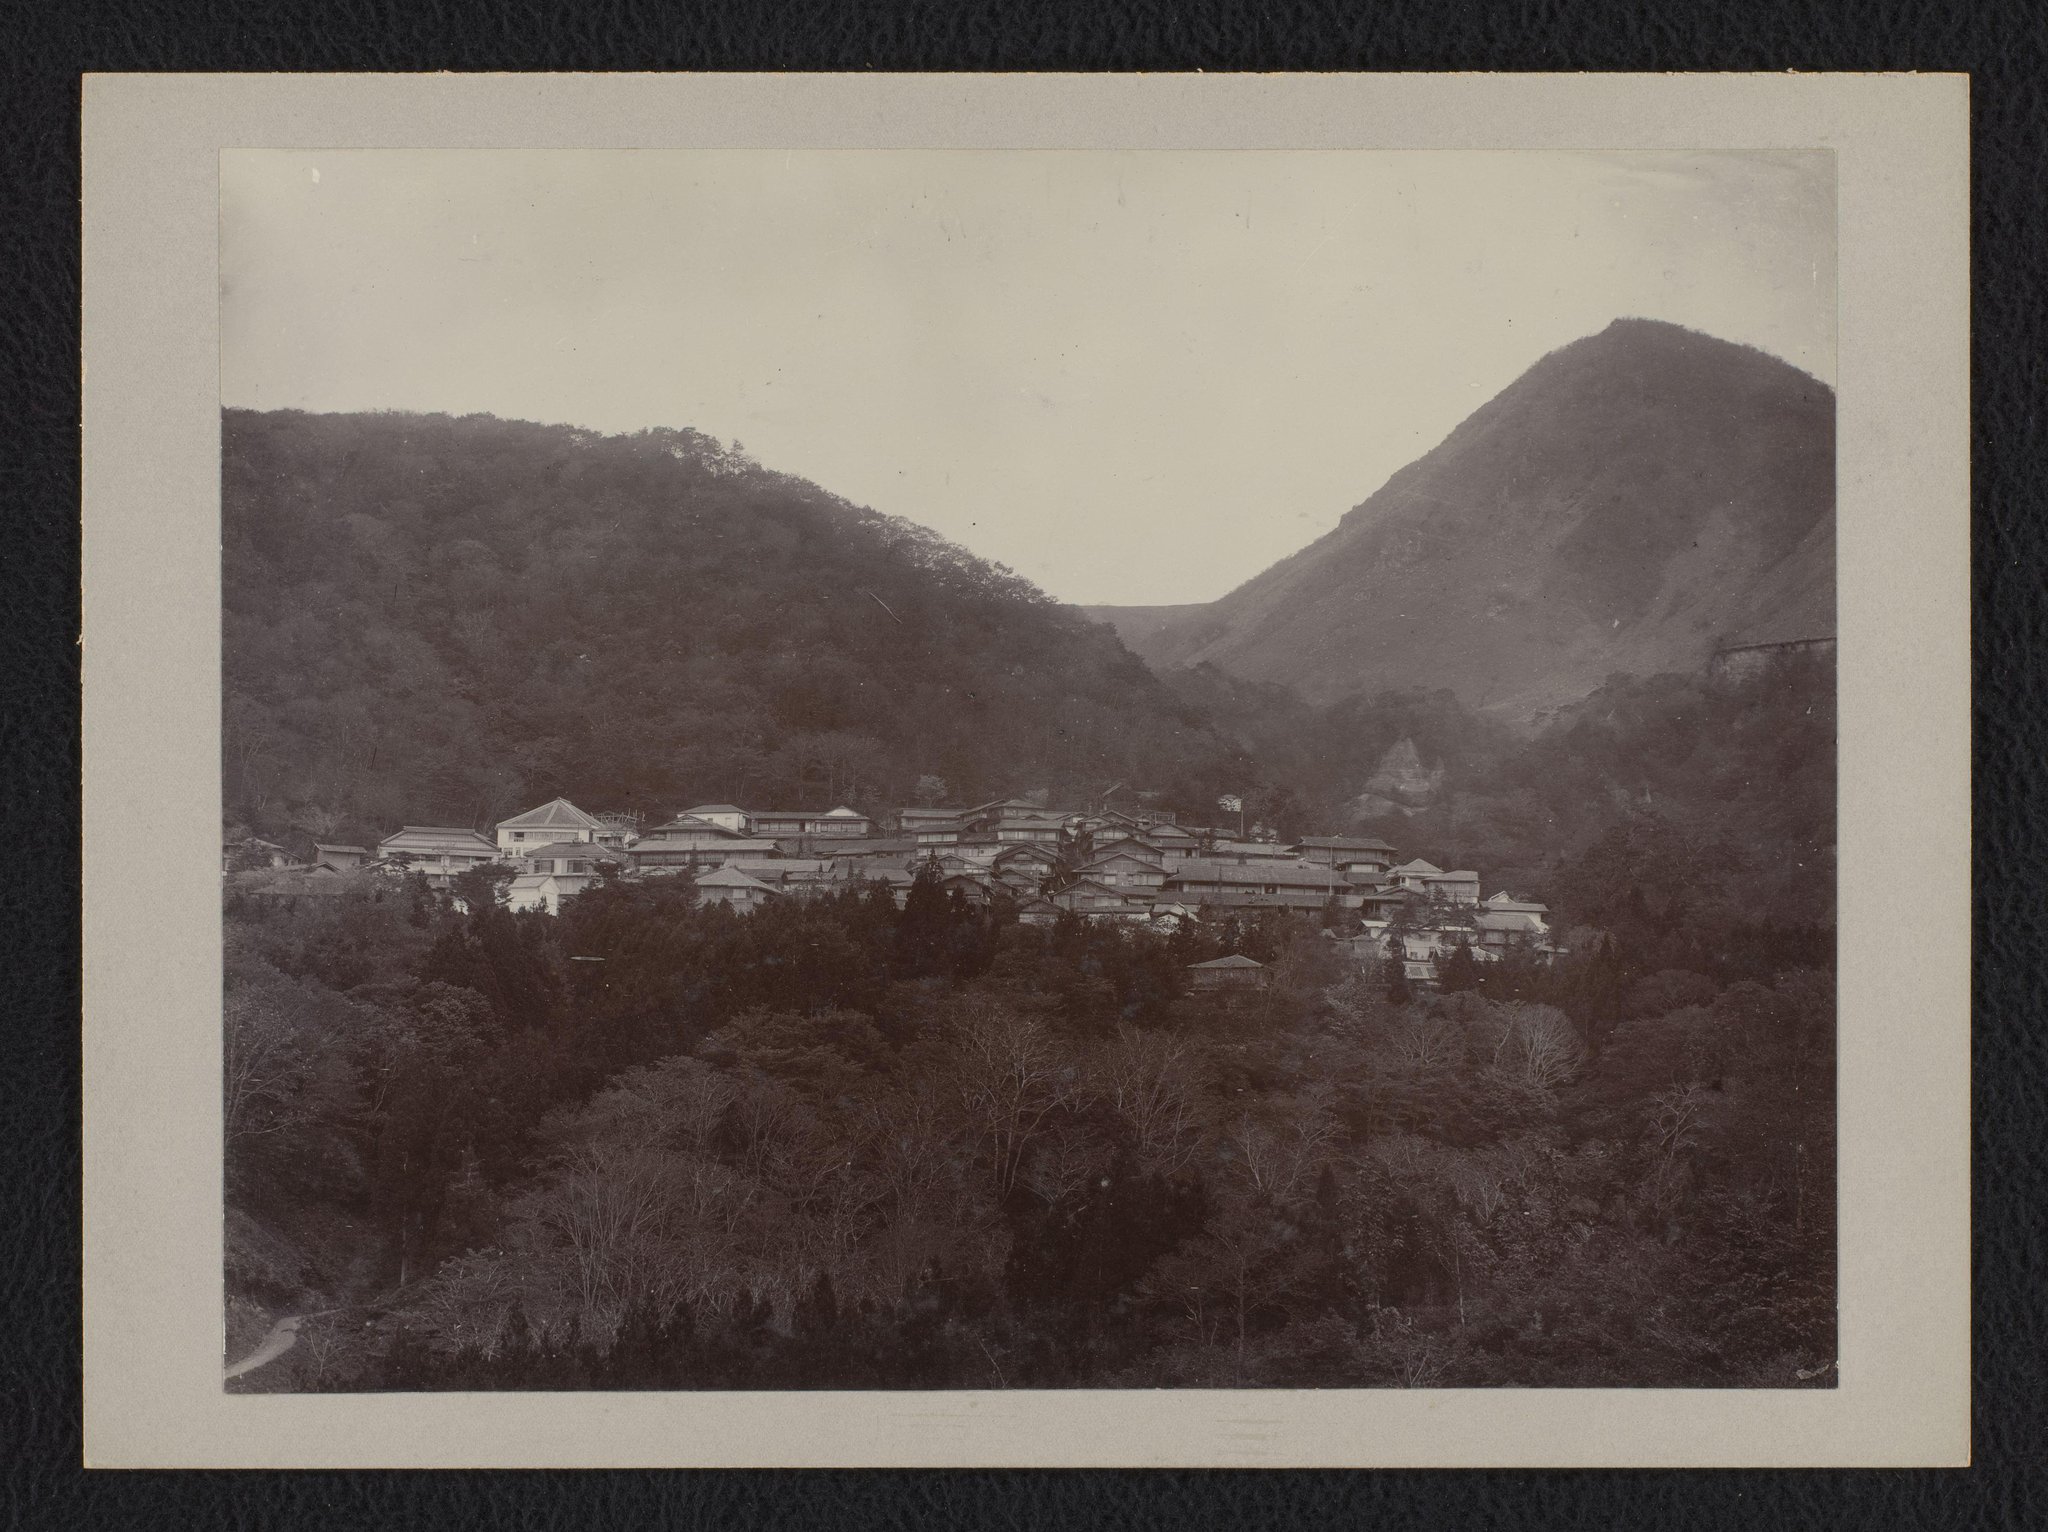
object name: photograph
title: Uitzicht op Ikaho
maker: Anonymous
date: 1895-1915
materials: cardboard, photographic support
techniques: collodion silver print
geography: ikaho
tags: ikaho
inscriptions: annotation: ‘41. Ikao.’